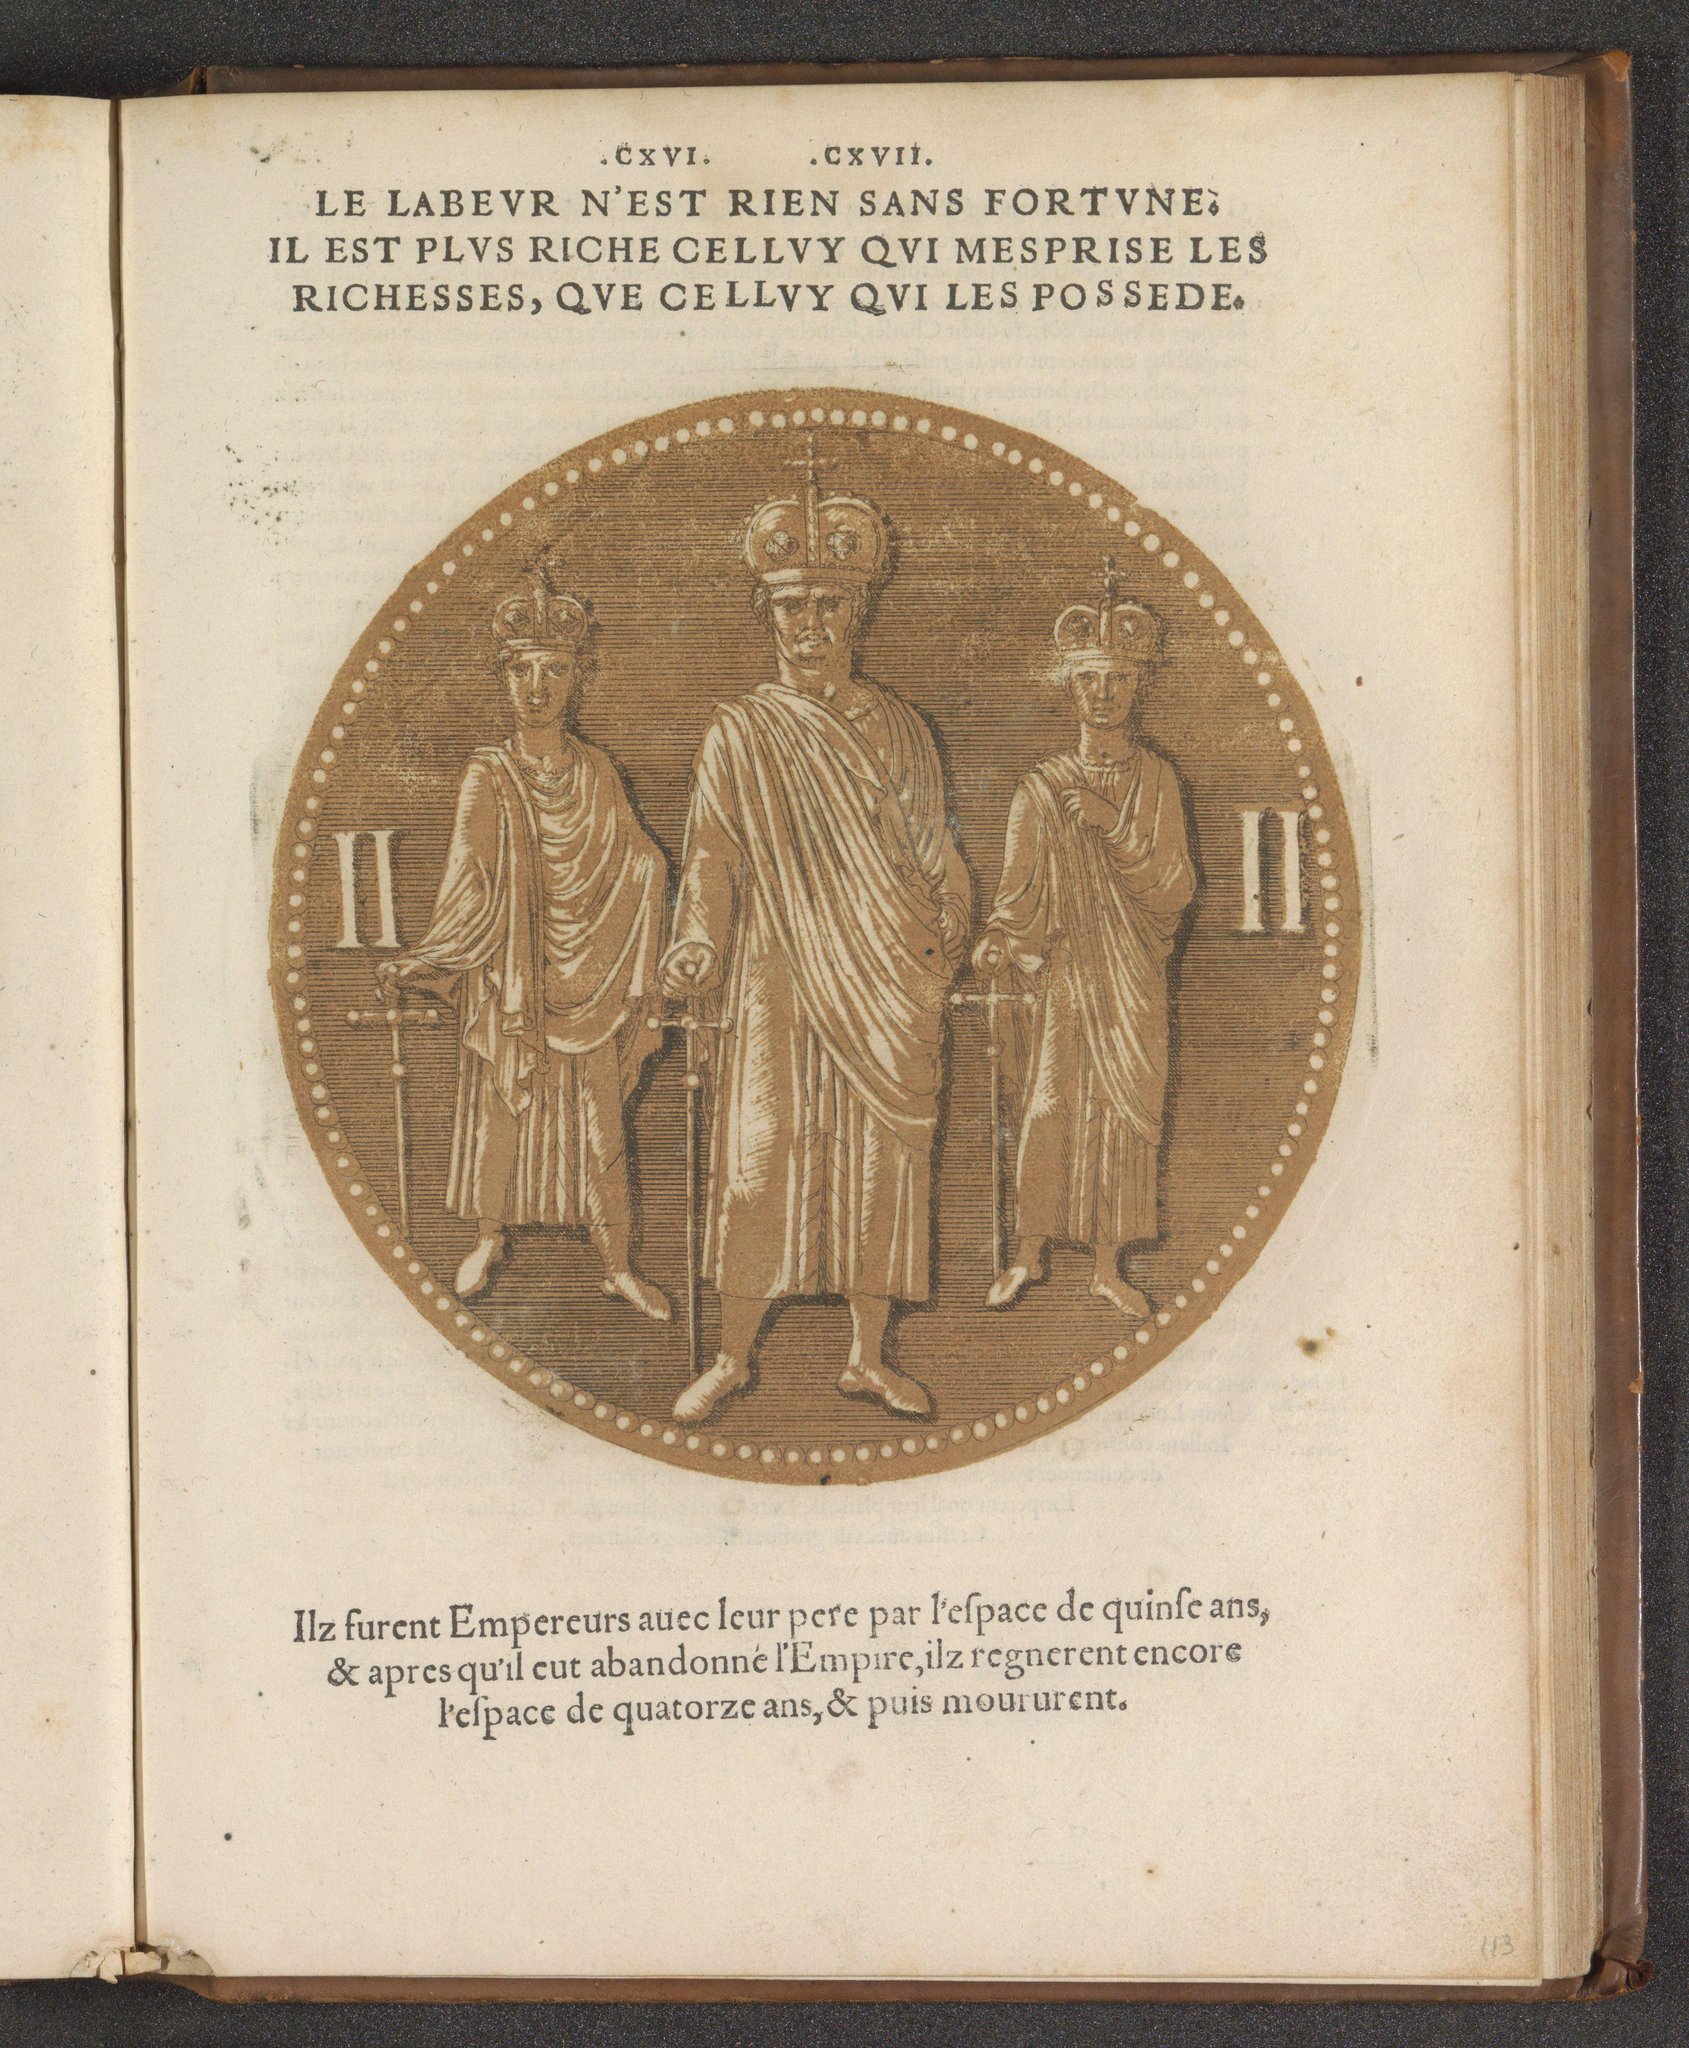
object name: page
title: Les images presque de tous les empereurs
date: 1557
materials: paper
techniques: woodcut, etching, letterpress printing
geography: antwerp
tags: emperor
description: Portretten van keizer Lodewijk II van Italië en zijn broers Karel van Provence en Lotharius II, samen op een munt met randschrift. De prent maakt deel uit van een boek over de keizers vanaf Julius Caesar tot en met Karel V en zijn broer Ferdinand.